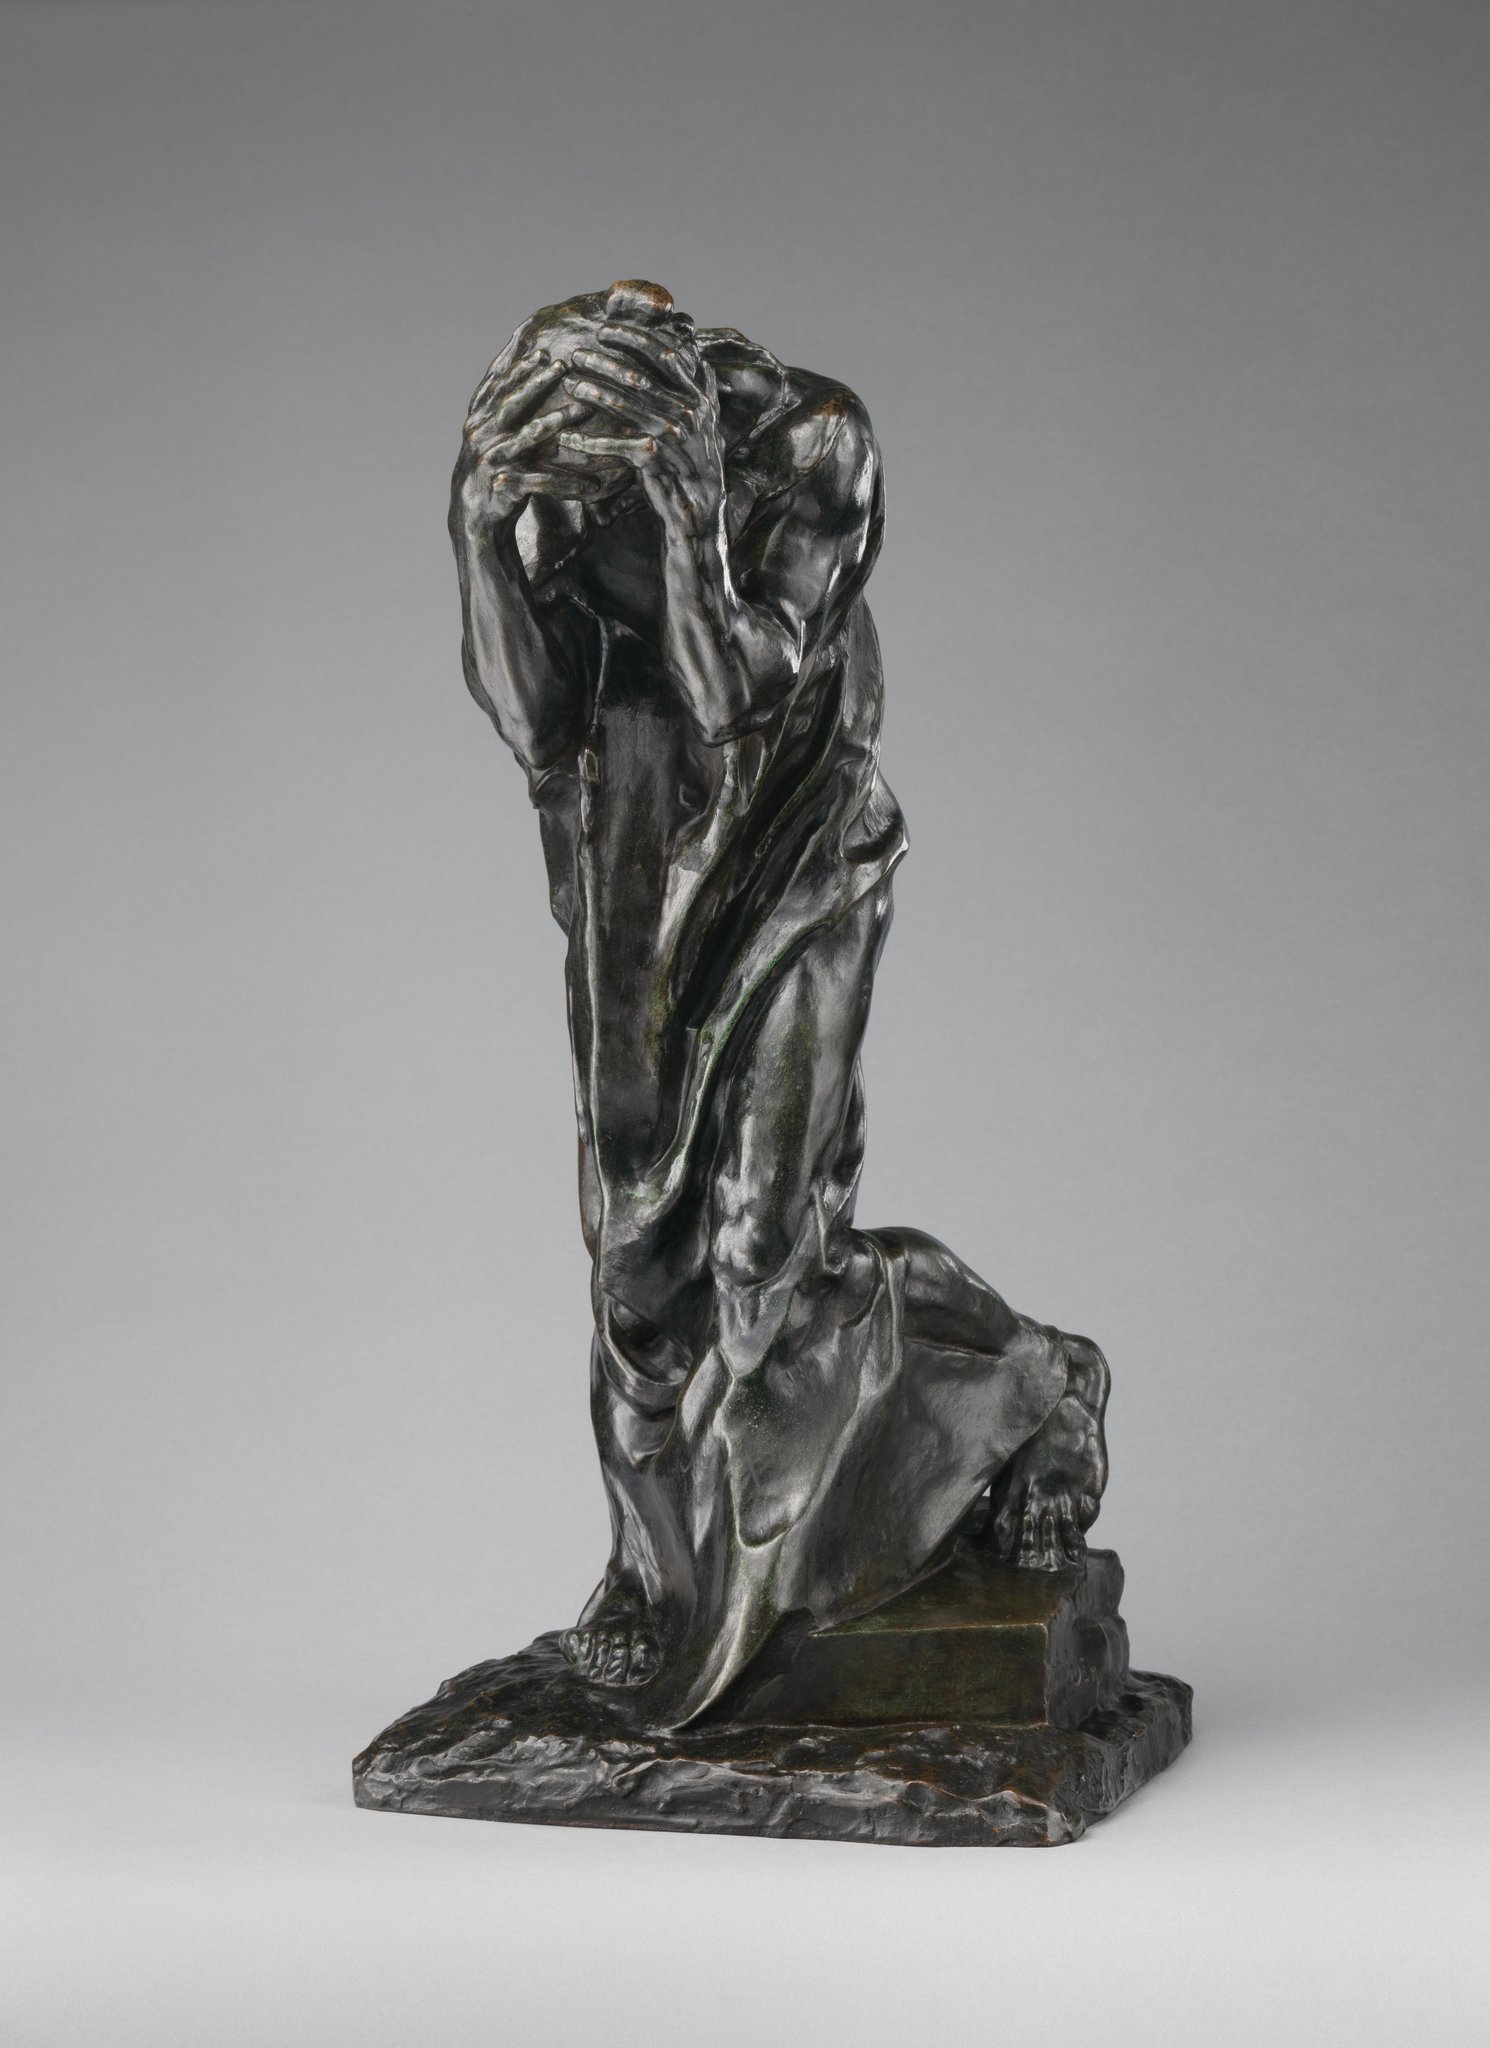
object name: statuette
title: The Weeping Burgher (Andrieu d'Andres)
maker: auguste rodin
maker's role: artist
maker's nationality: french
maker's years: 1840-1917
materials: bronze, patina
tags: sadness,men